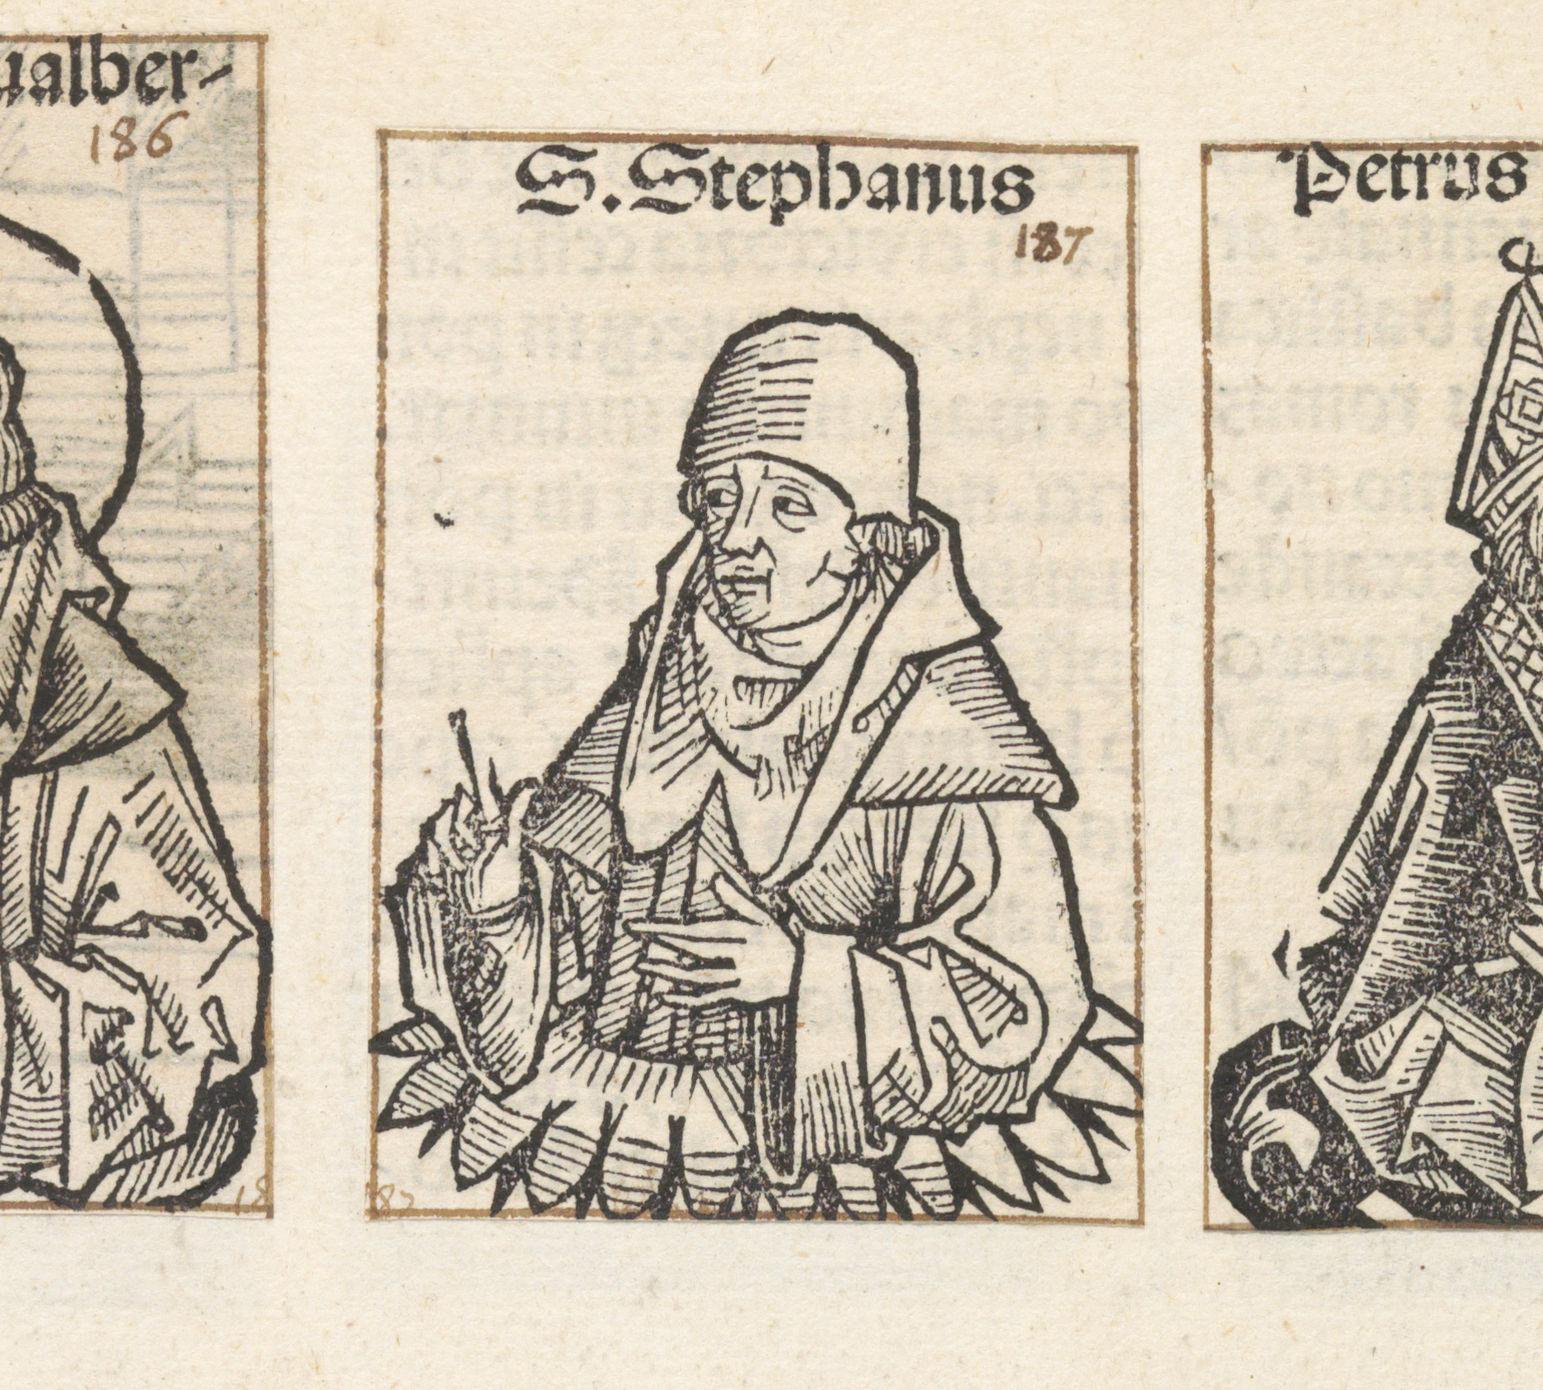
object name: book illustration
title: S. Stephanus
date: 1493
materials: paper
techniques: letterpress printing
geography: nuremberg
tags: saints, monk(s), friar(s)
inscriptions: inscription: ‘187’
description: De houtsnede wordt herhaaldelijk gebruikt als boekillustratie in de Liber Chronicarum (of Neurenbergkroniek) van Hartmann Schedel, verschenen in het Latijn en Duits in 1493. Zie de Latijnse uitgave, folio 192v.